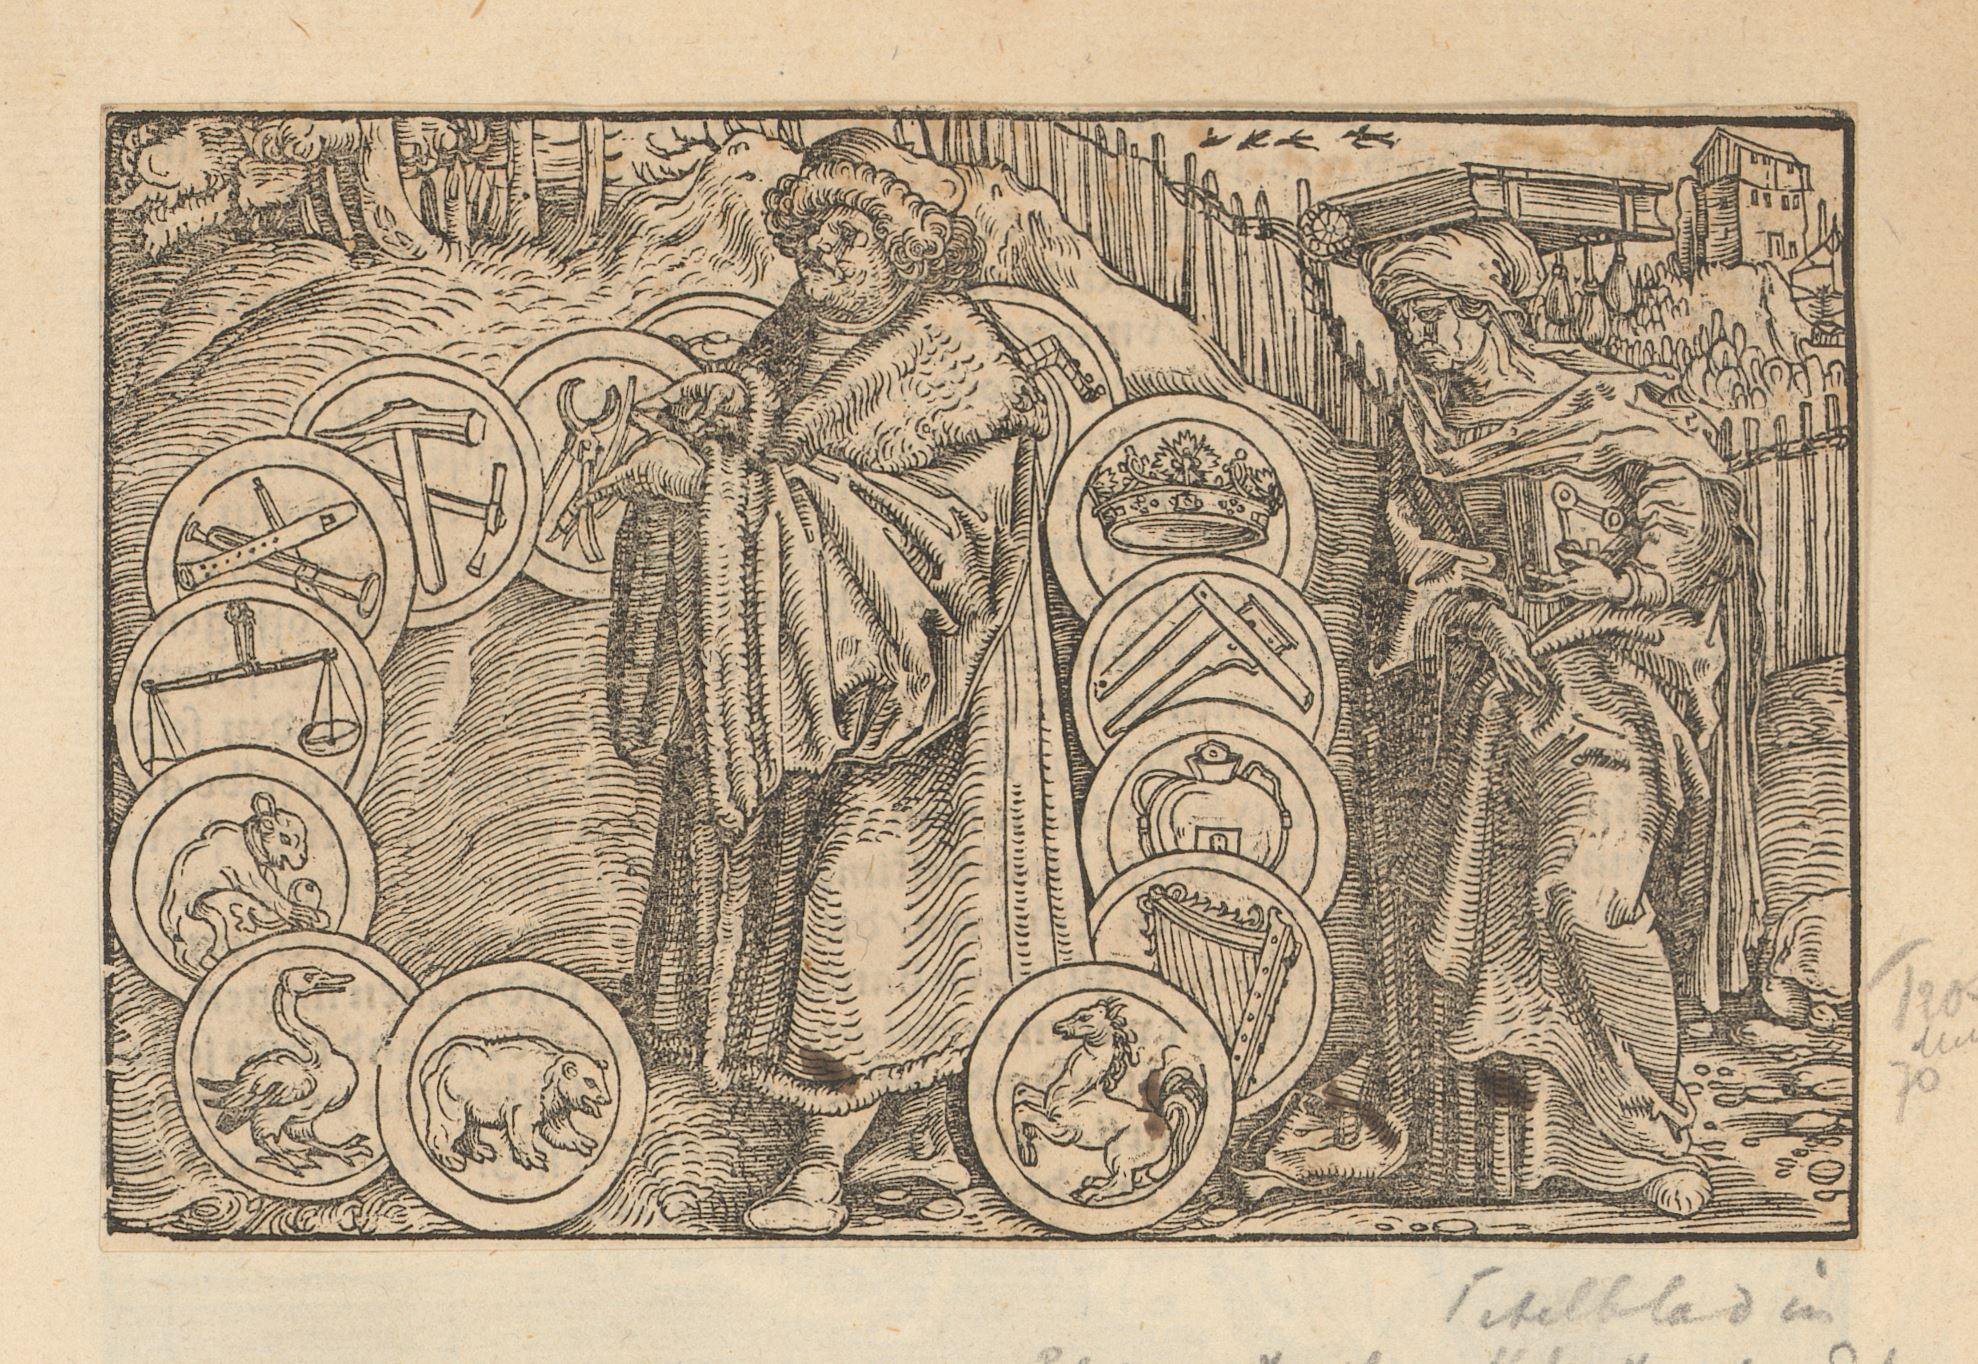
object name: book illustration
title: Geleerde omringd door emblemen met heraldiek en de personificatie van Wijsheid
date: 1514-1532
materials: paper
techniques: letterpress printing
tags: wisdom; 'sapienza', 'sapienza humana', 'sapienza vera' (ripa), the books of wisdom, abstract ideas and concepts (+ abstract concept represented by female figure), armorial bearing, heraldry, 'litterae', symbolic representations, allegories and emblems ~ literature; 'lettere' (ripa)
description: Deze prent is gebruikt in: Petrarca, Francesco. Von der Artzney bayder Glück, des guten und widerwertigen: unnd weß sich ain yeder inn Gelück und Unglück halten sol (...). Augsburg: Heinrich Steiner, 1532. Deze uitgave is ook bekend onder de titel 'Trostspiegel in Glück und Unglück'. Deze prent is ook gebruikt in: Cicero, Marcus Tulius. Officia M.T.C. Ein Buch so Marcus Tullius Cicero der Römer zu seynem (...). [Vertaald uit het Latijn door] Johann von Schwarzenberg. Augsburg: Heinrich Steiner, 1531. De prent is ook gebruikt op de titelpagina van: Urban, Vergilius Polydorus von. Von den Erfindern der ding (...). [Vertaald uit het Latijn door] Marcus Tatius Alpinus. Augsburg: Heinrich Steiner, 1537.